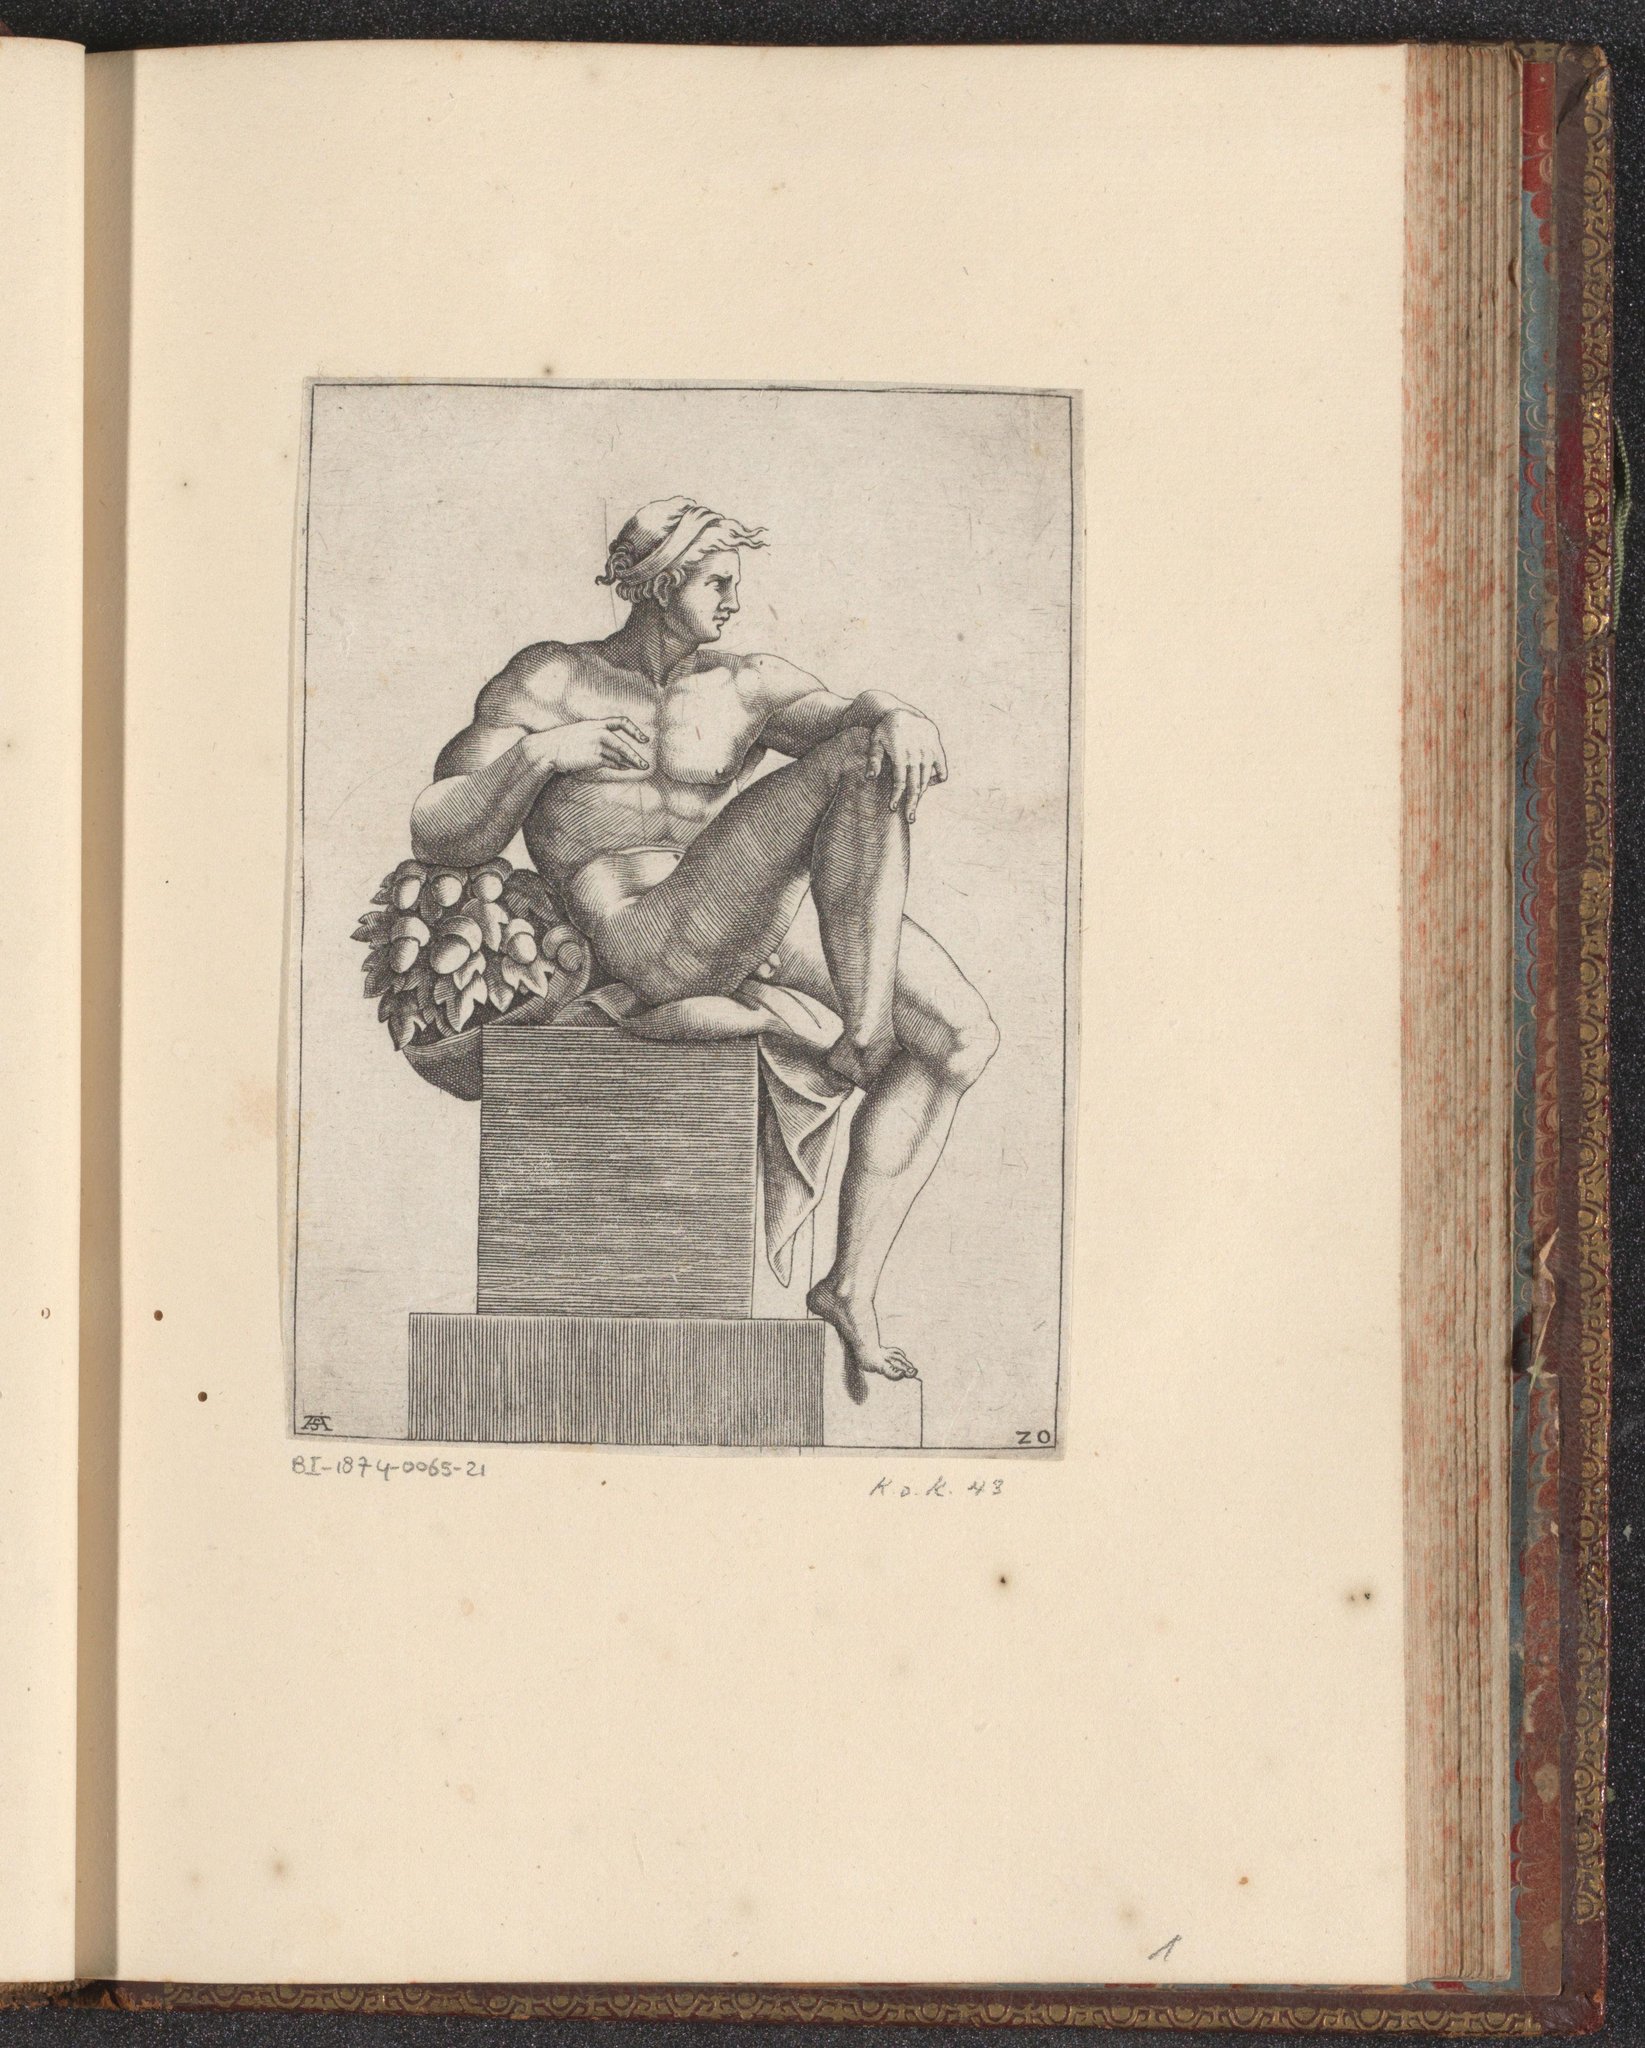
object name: album leaf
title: Zittend naakt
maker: adamo scultori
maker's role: painter, print maker, sculptor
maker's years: 1530-1585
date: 1585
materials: paper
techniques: engraving, intaglio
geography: italy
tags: the (nude) human figure; 'corpo humano' (ripa), fruits: acorn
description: Zittende naakte man, naar rechts gedraaid met opgetrokken been en een guirlande van eikels. Eén van de 'ignudi' (naakte mannen) van Michelangelo's plafondschildering. Genummerd rechtsonder: 20. De prent maakt deel uit van een album.